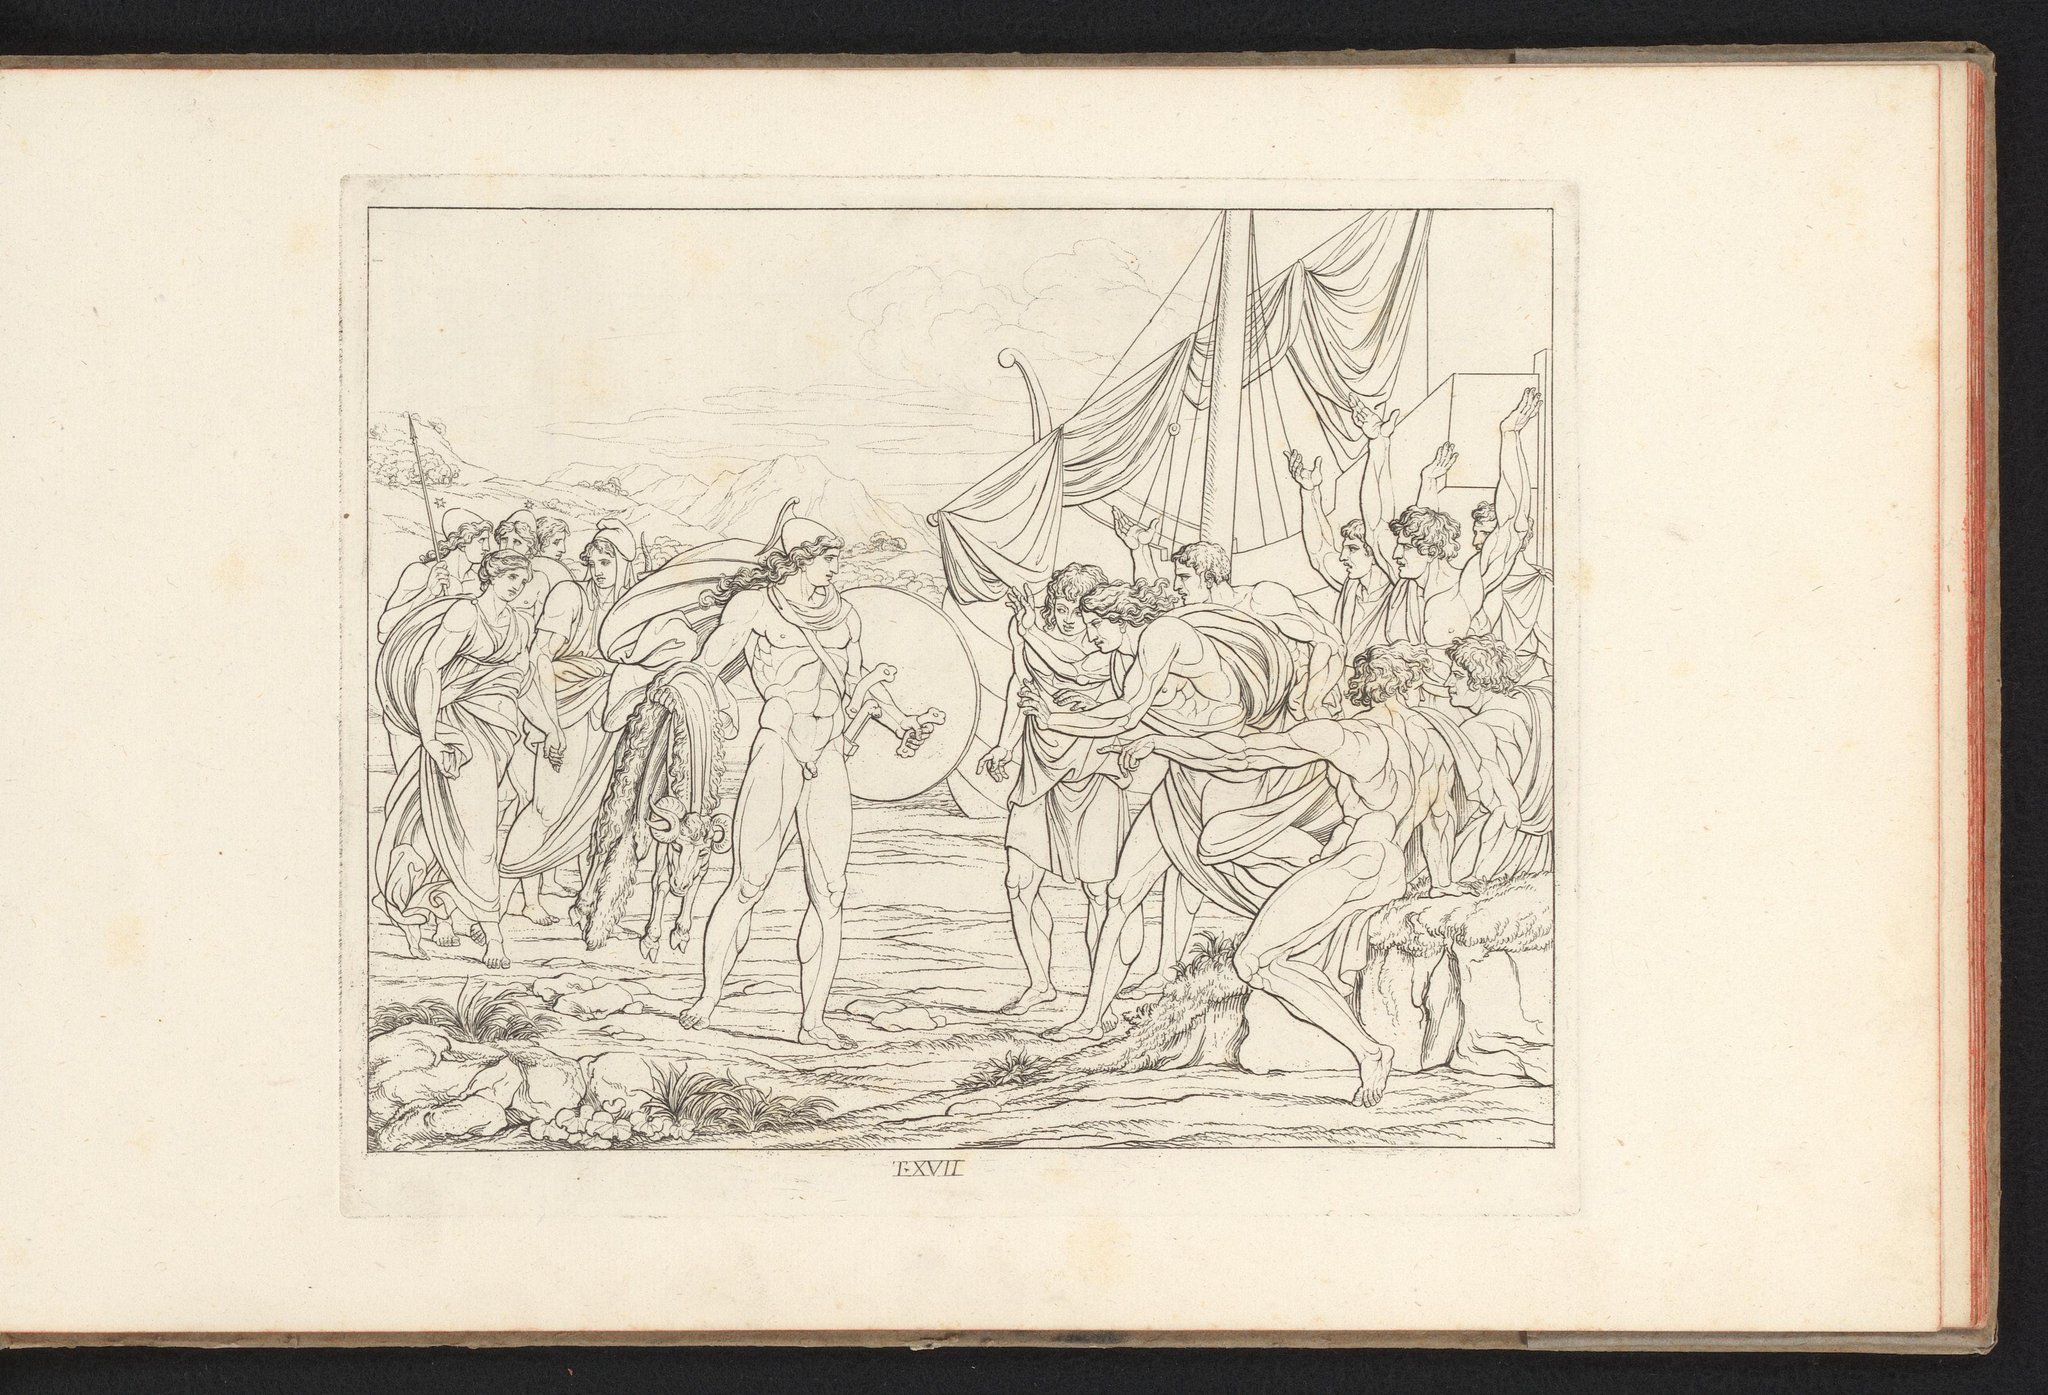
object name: print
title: Jason en de Argonauten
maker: joseph anton koch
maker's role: draughtsman, painter, print maker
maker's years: 1768-1839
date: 1799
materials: paper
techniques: etching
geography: rome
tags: the golden fleece, hanging on an oak-tree, is seized by jason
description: Deze prent maakt deel uit van een serie met 24 prenten.